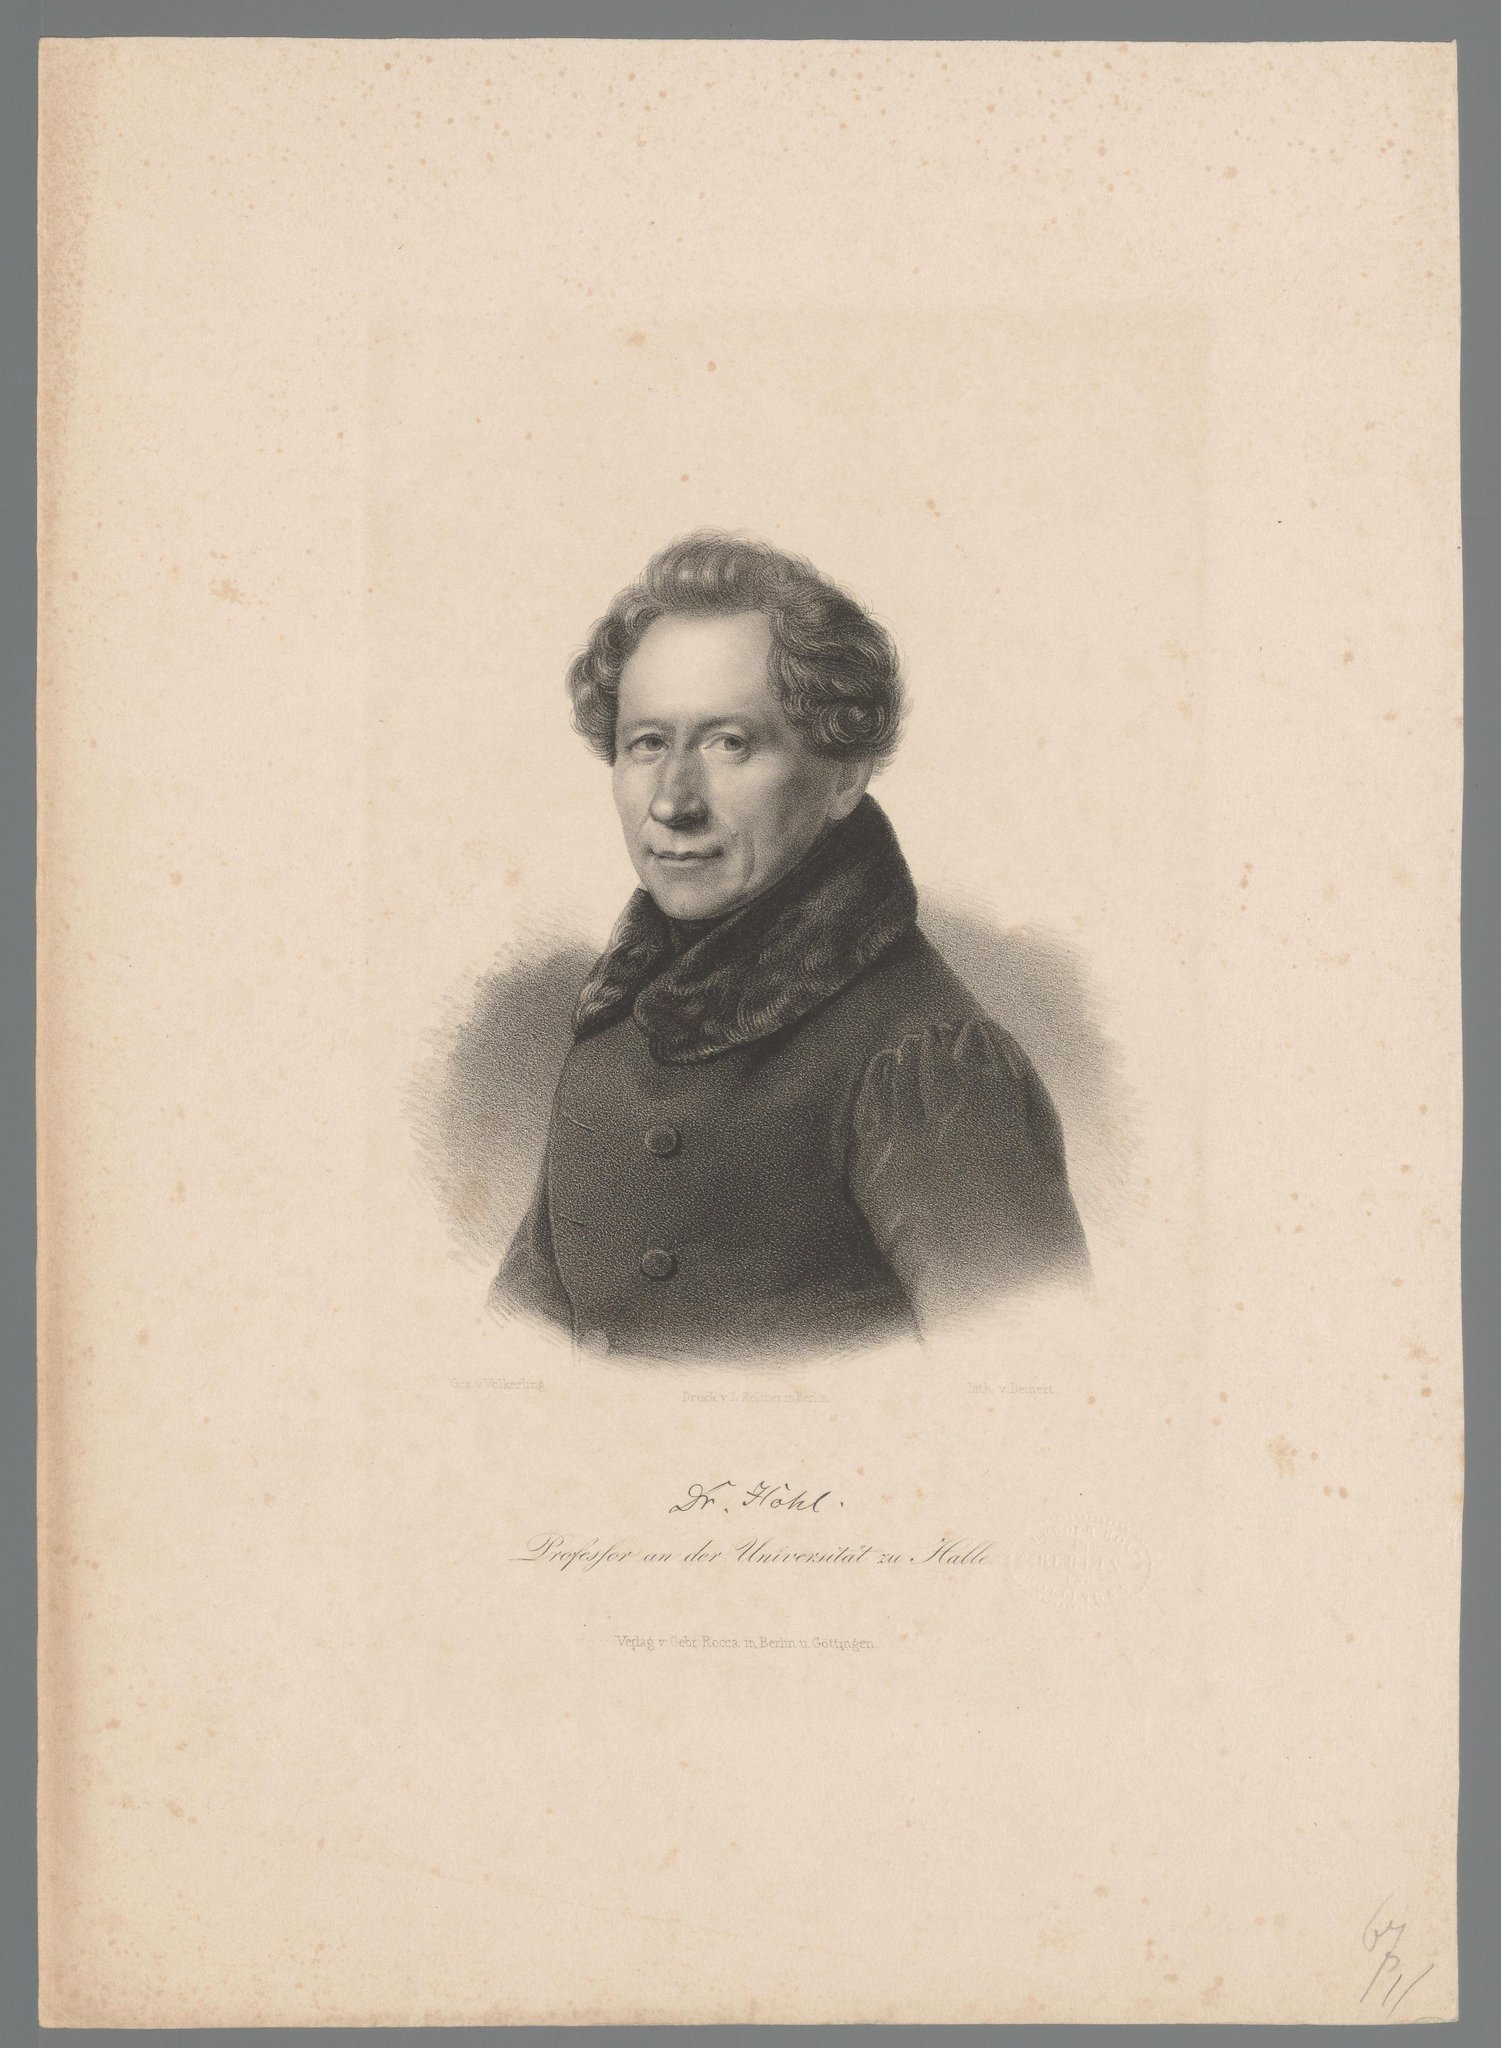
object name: print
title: Portret van Hohl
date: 1830-1863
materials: paper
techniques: lithograph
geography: berlin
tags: adult man, historical persons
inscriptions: check stamp: Lugt 5514, collector's mark: Lugt 2228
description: Portret van een verder onbekende man, met de naam Hohl.